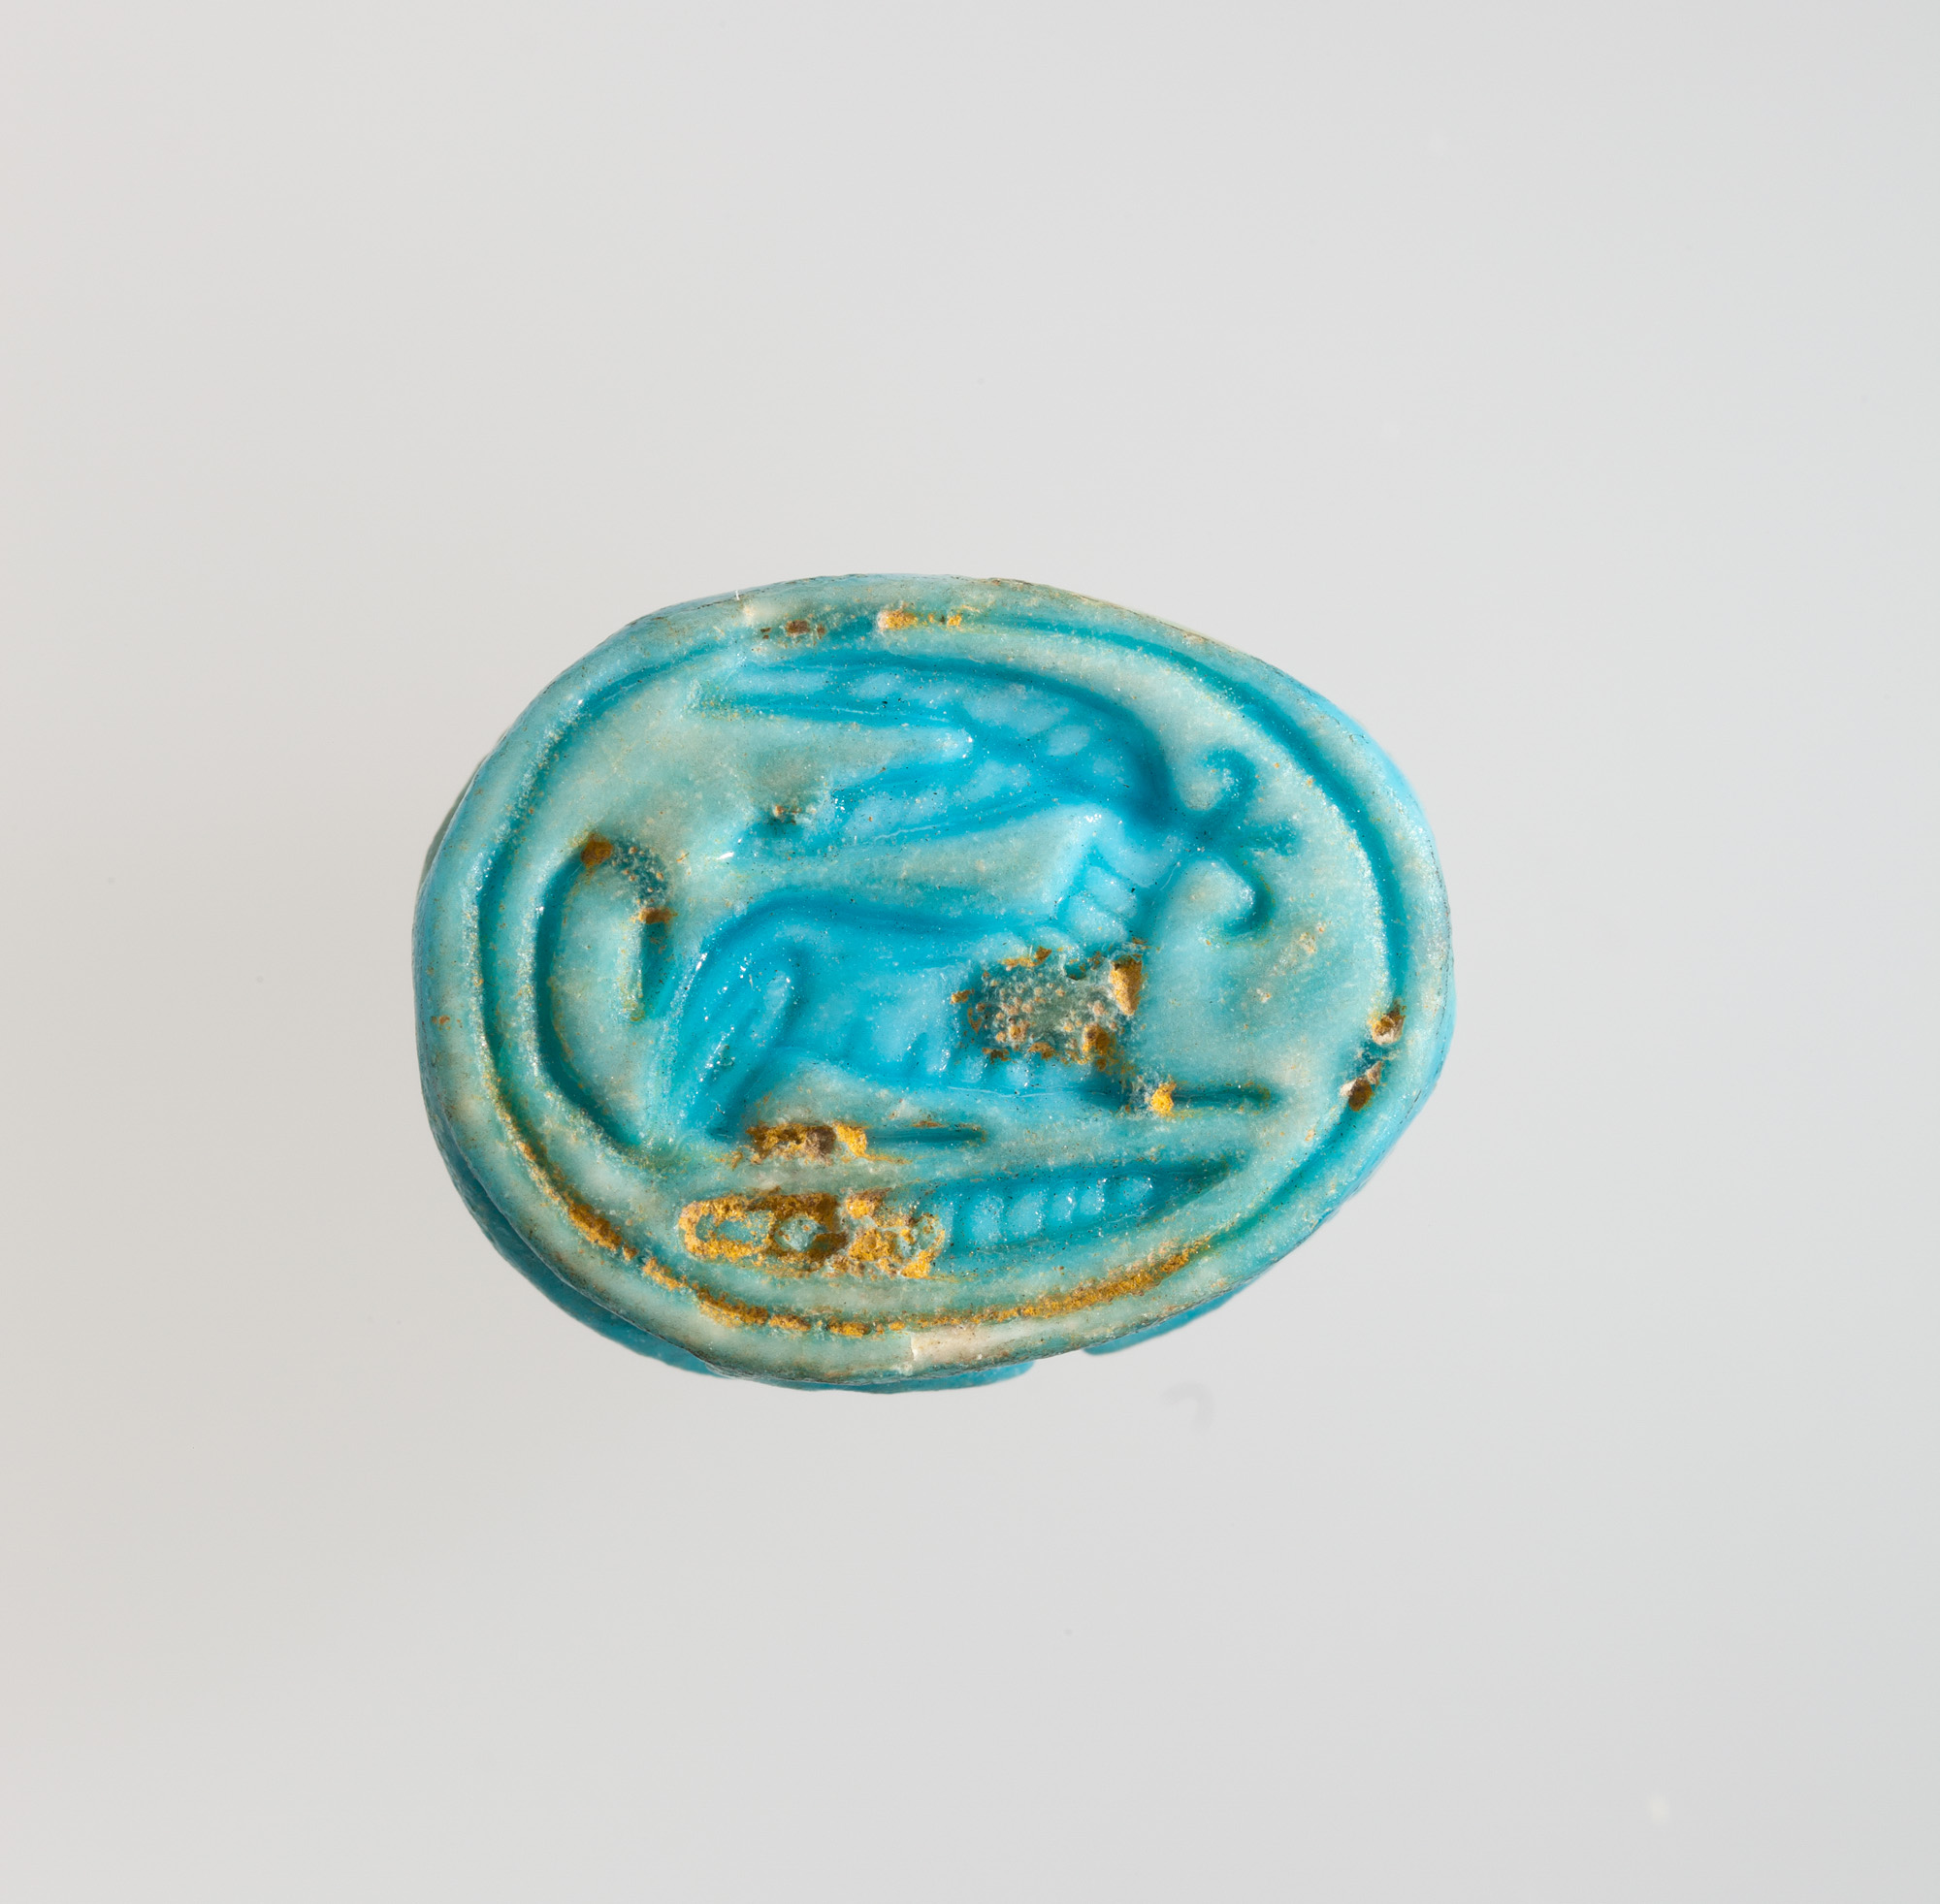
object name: scarab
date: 1479-1458 BCE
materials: faience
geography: egypt